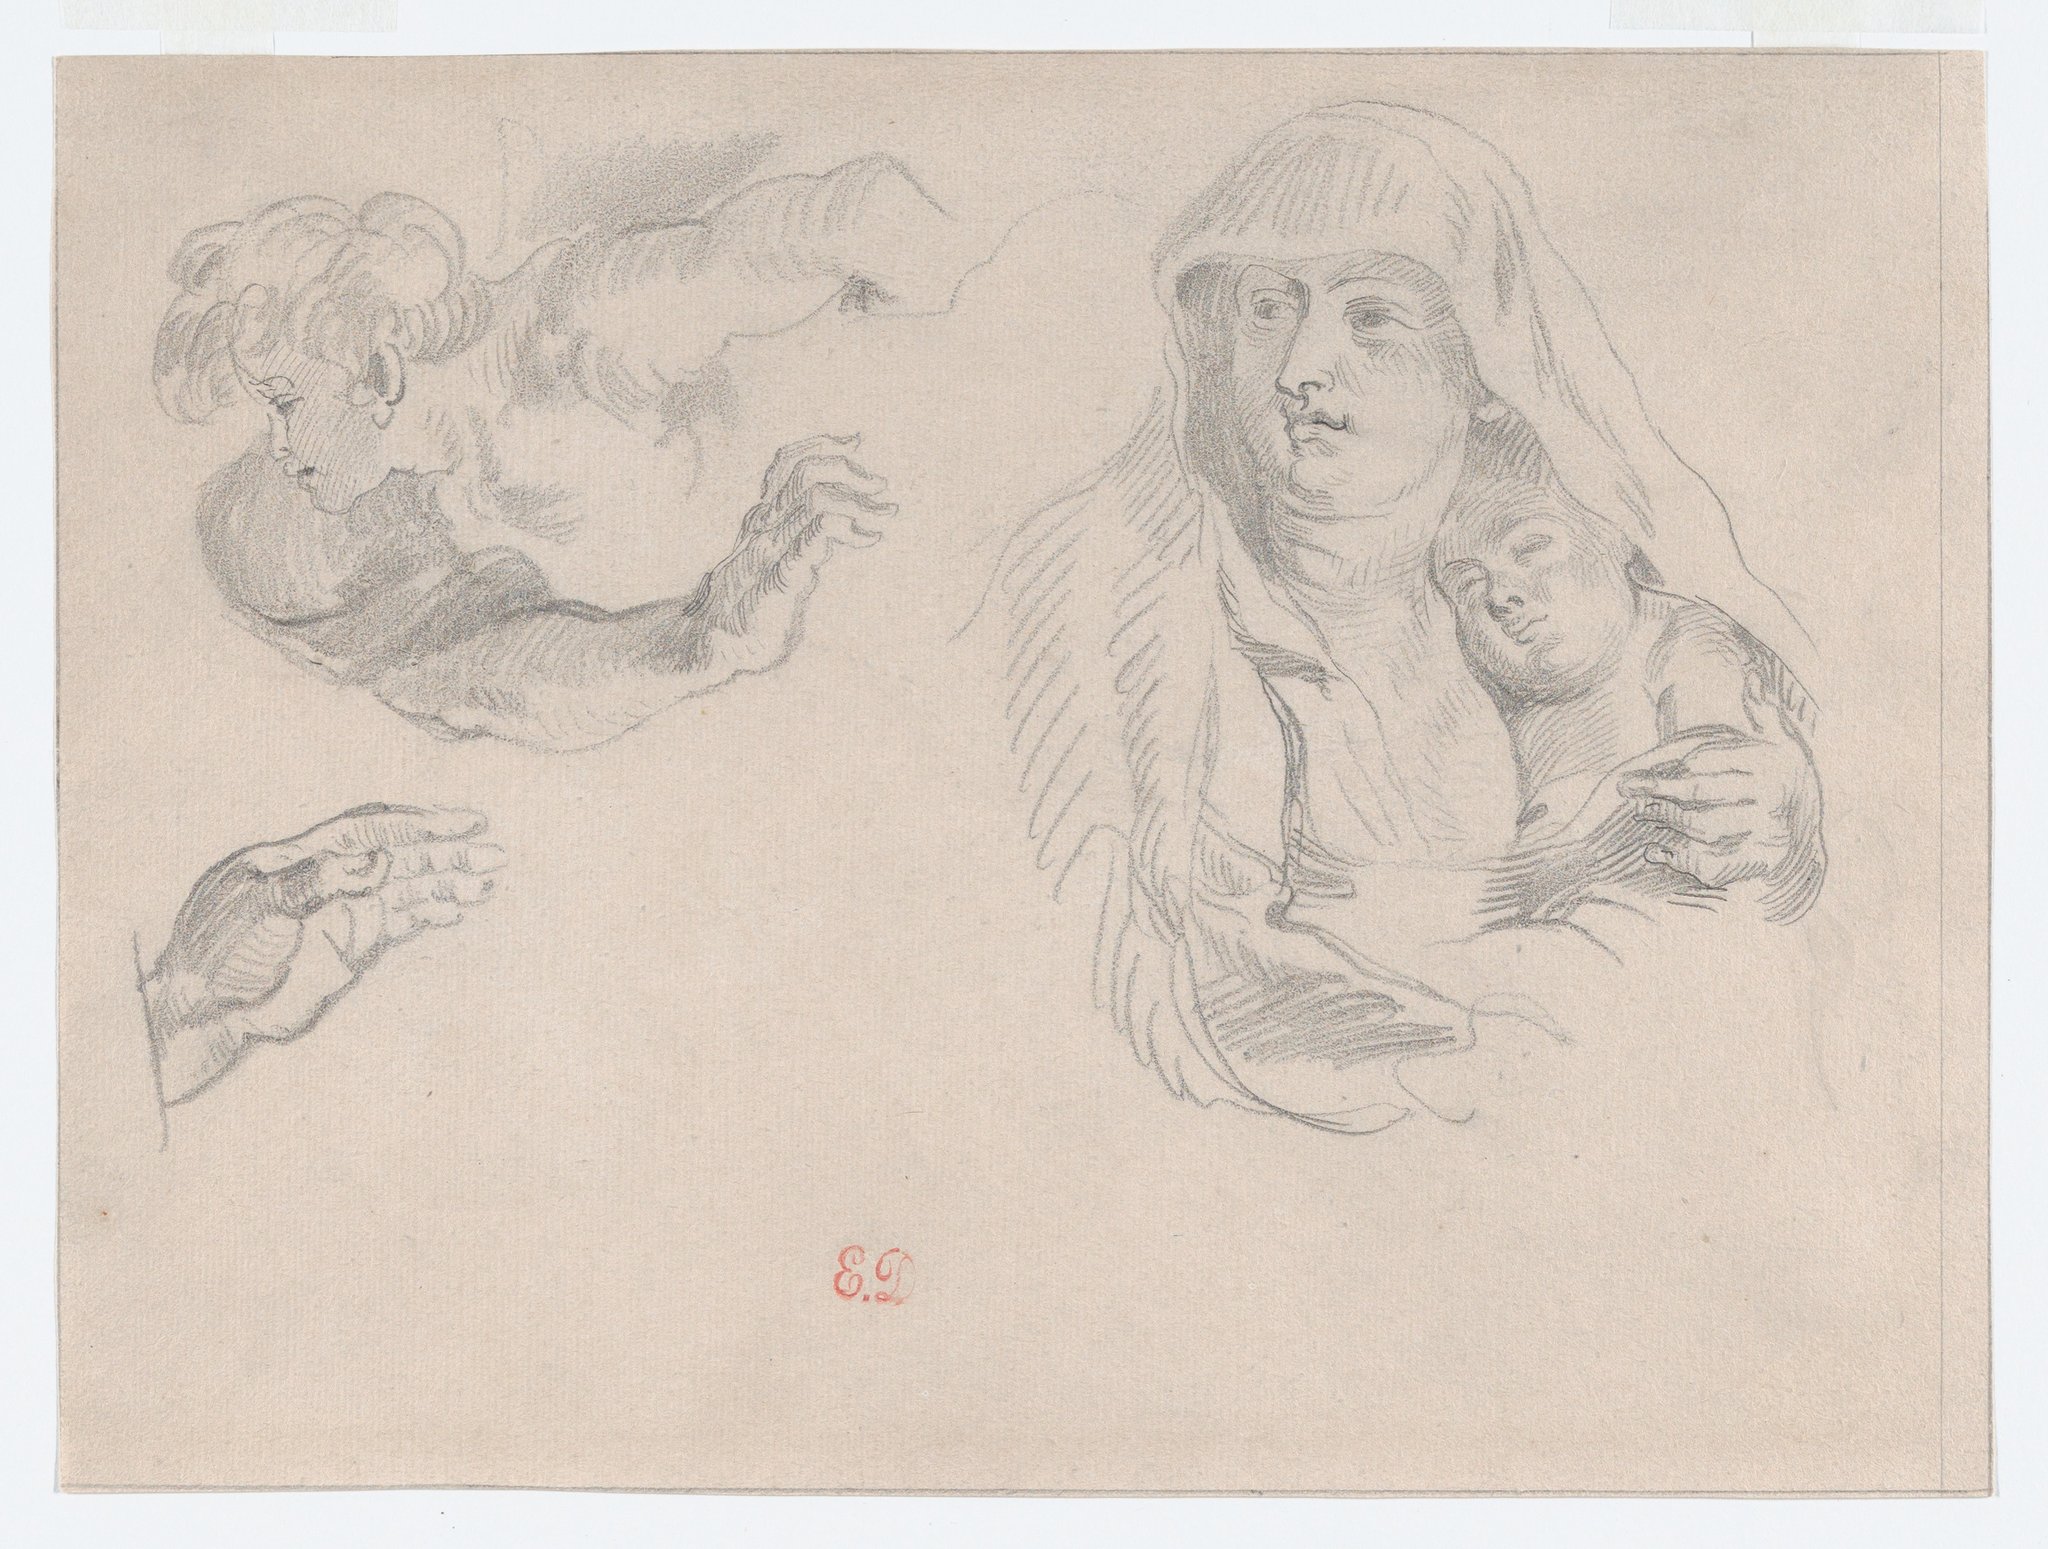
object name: drawing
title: Studies after Rubens’s “The Flight into Egypt”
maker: eugène delacroix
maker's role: artist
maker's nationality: french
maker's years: 1798-1863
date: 1830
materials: graphite